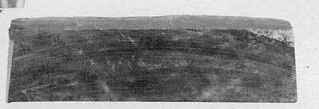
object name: fragment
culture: russian, siberia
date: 1902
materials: jade